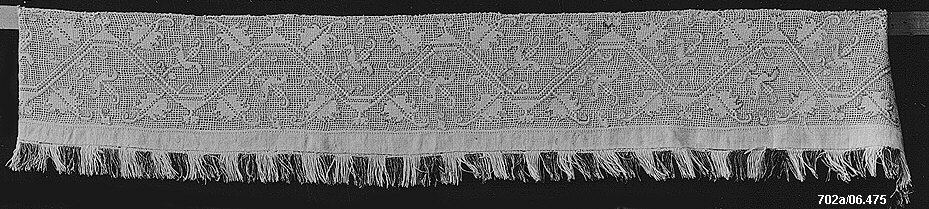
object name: border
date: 1601-1700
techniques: embroidery